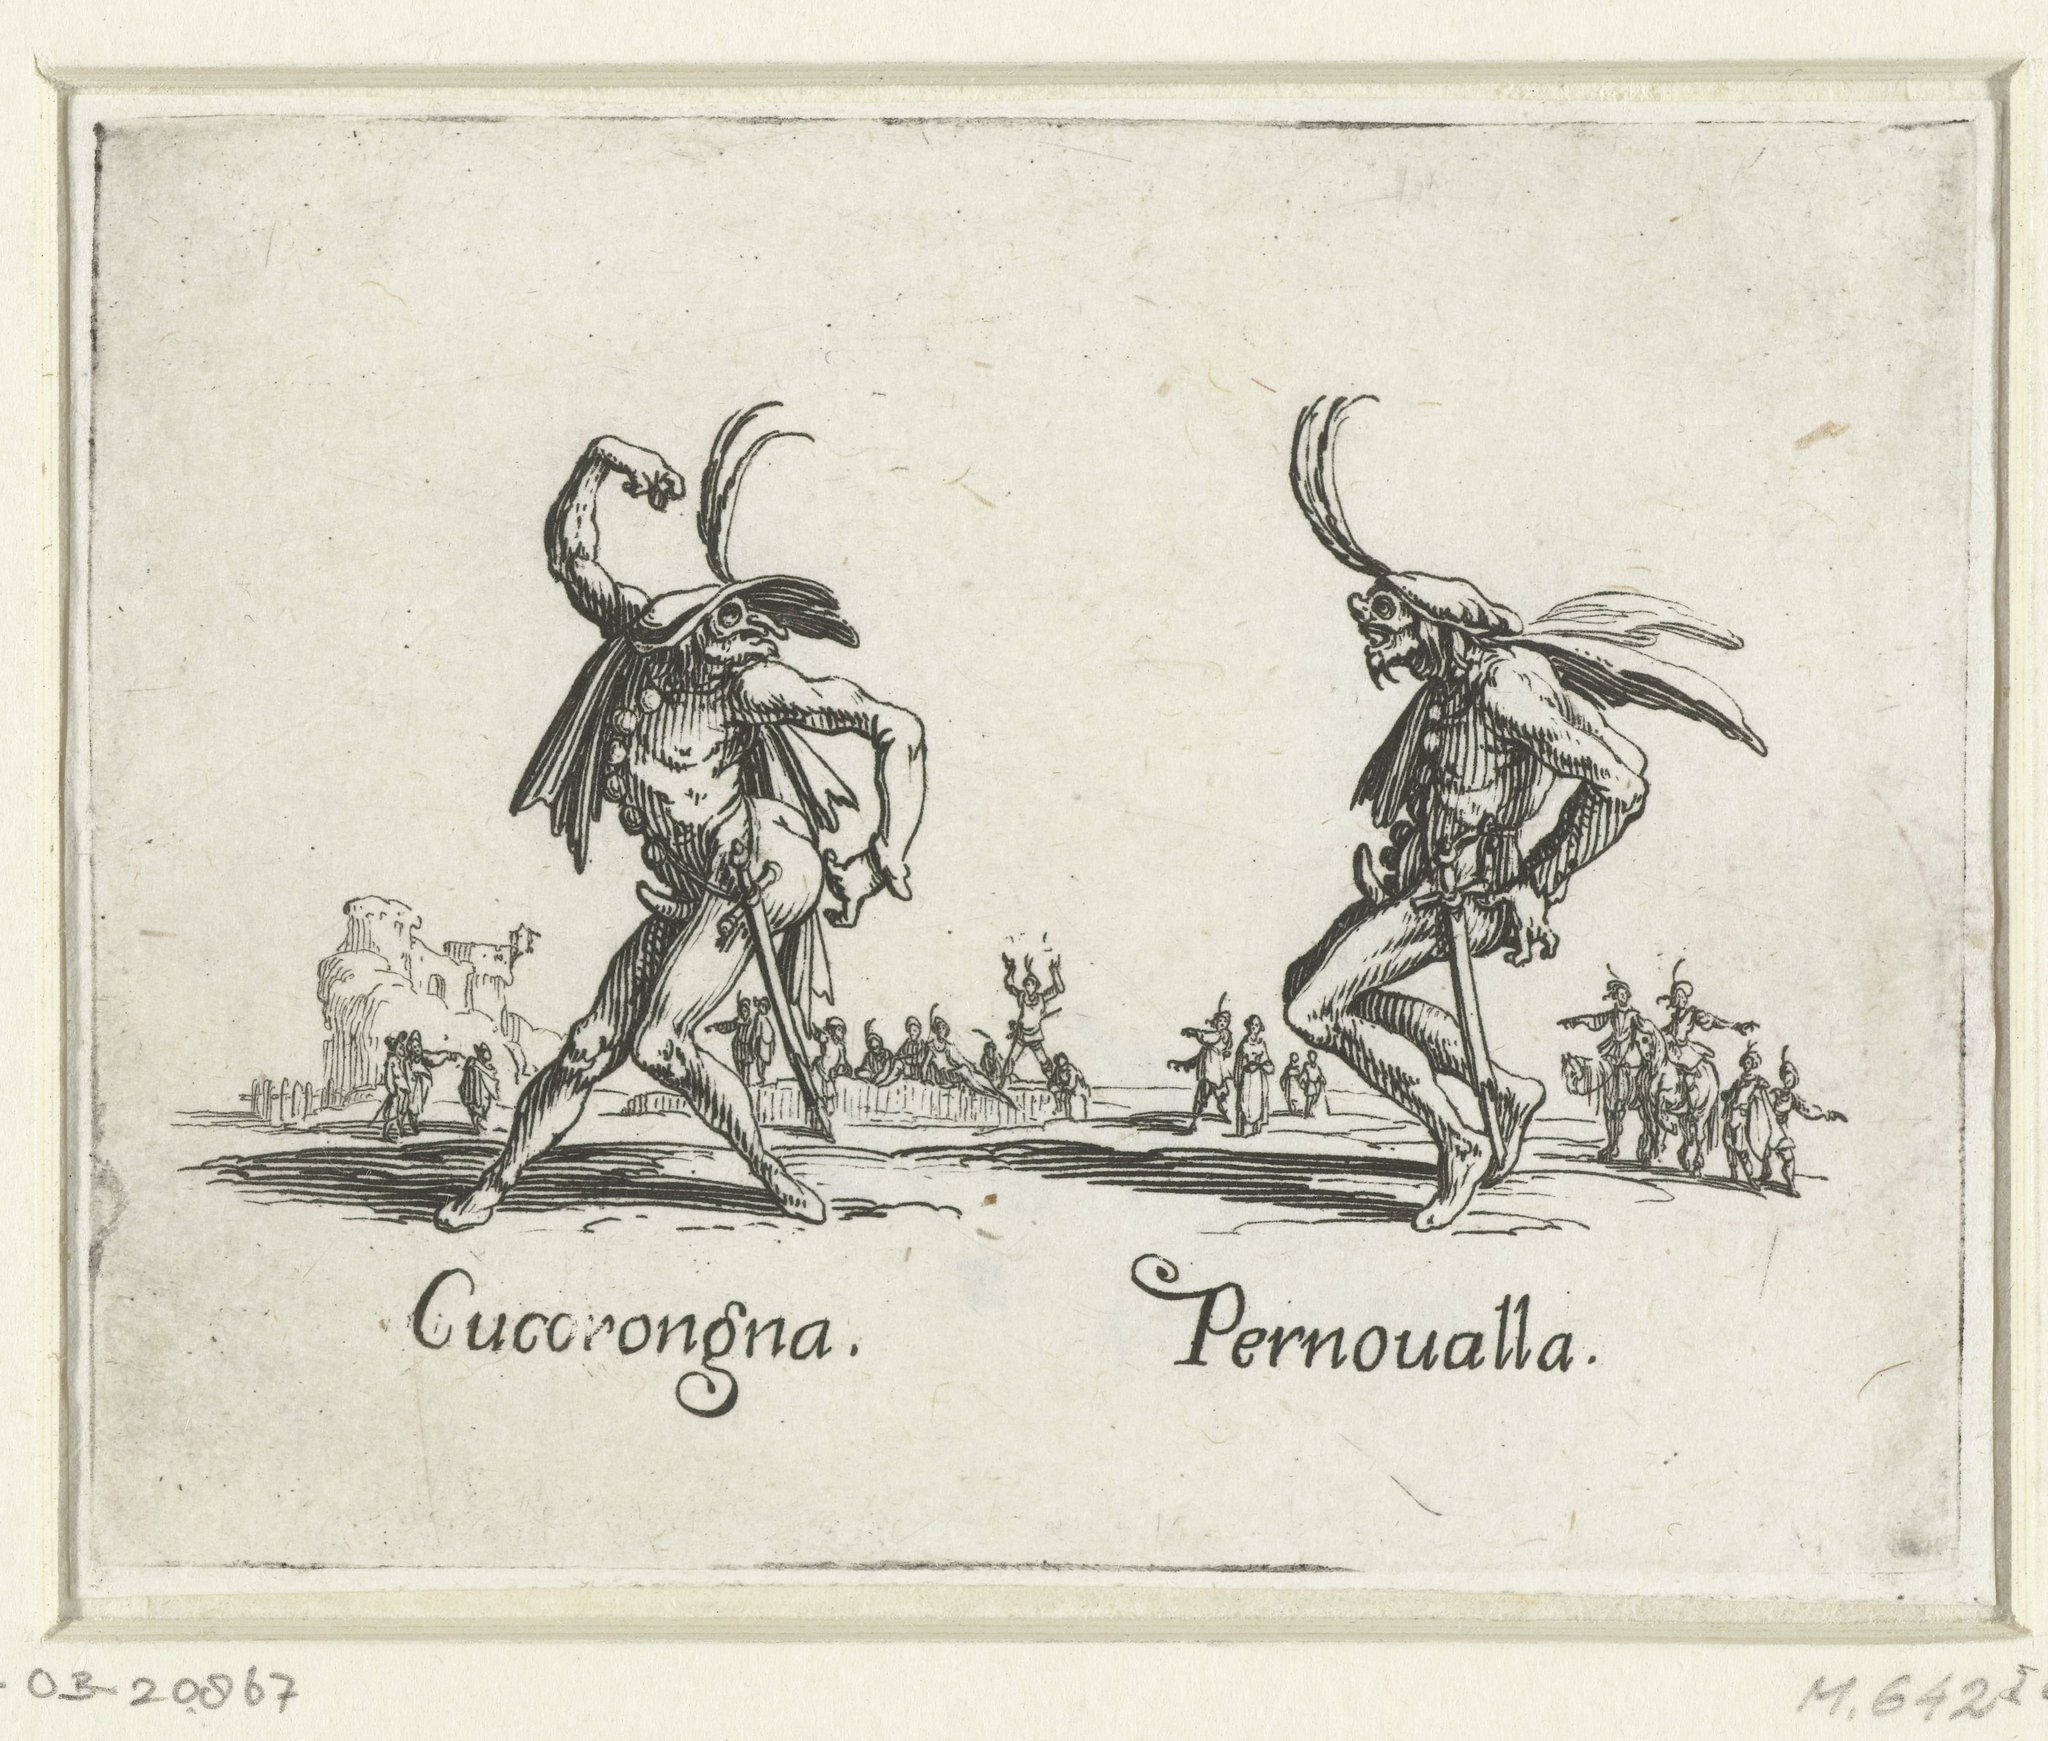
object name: print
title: Twee straatartiesten als Cucorongna en Pernoualla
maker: jacques callot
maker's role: draughtsman, print maker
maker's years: 1592-1635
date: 1621-1622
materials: paper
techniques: etching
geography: nancy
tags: types in 'commedia dell'arte', dancing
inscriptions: collector's mark: Lugt 240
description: Twee artiesten met gevederde hoofddeksels op dansen naast elkaar. Onder de figuren staan hun namen genoteerd. Deze prent is onderdeel van een serie van 23 prenten (24 incl. titelprent) met telkens op de voorgrond twee straatartiesten verkleed als figuren uit de Italiaanse commedia dell'arte, en op de achtergrond toeschouwers die in de buitenlucht een (dans)voorstelling van straatartiesten gadeslaan.